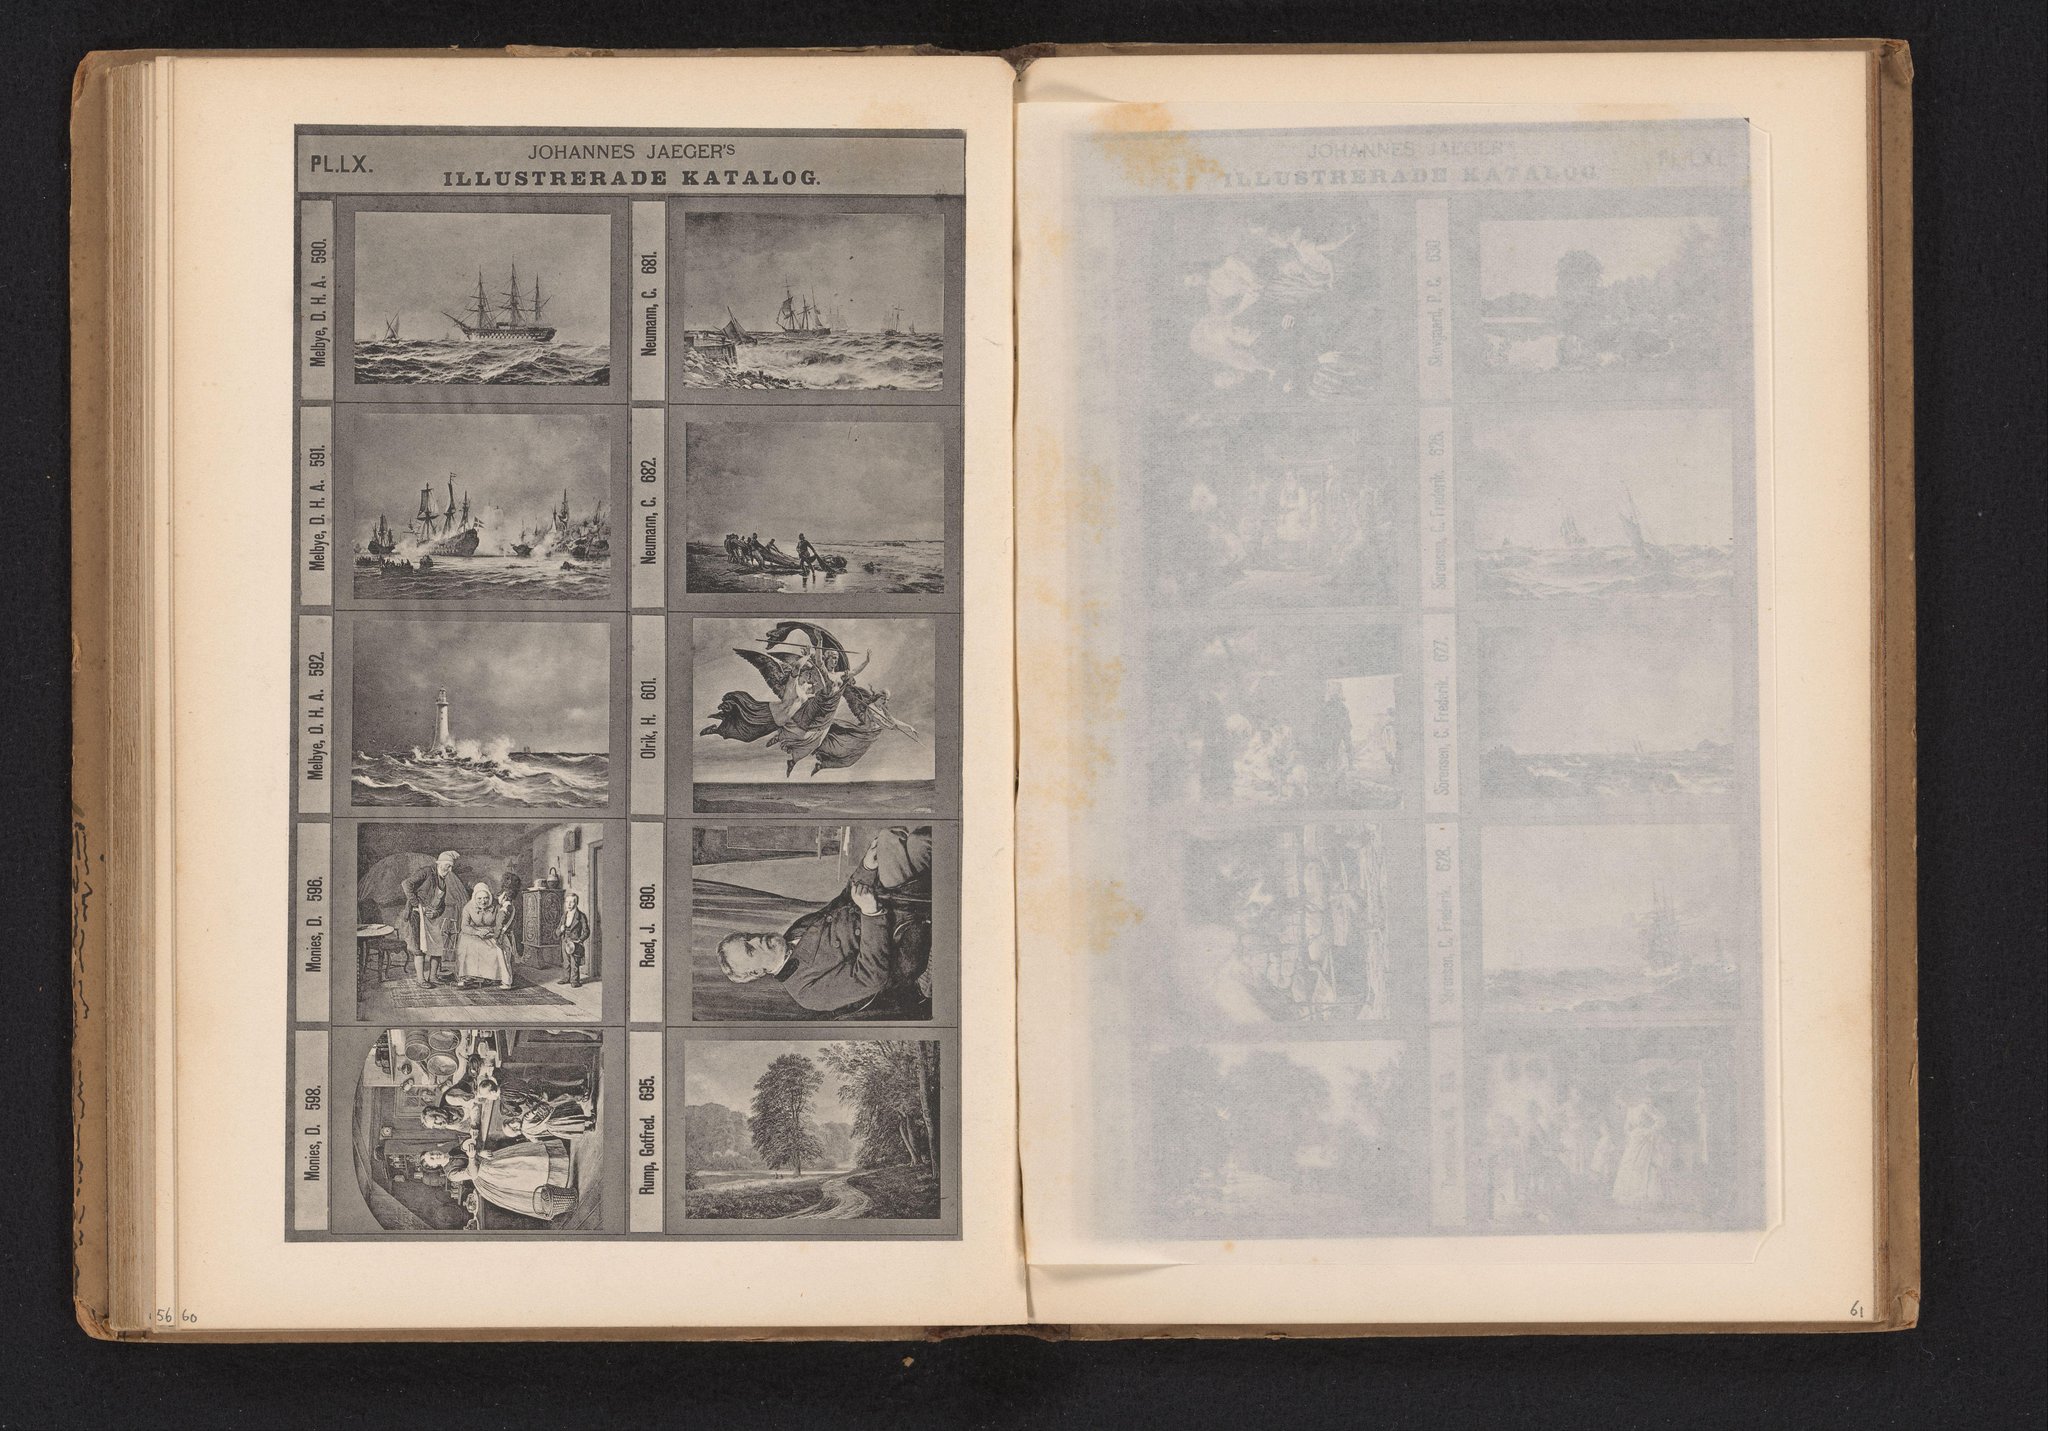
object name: reproduction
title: Johannes Jaeger's Illustrerade Katalog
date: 1872-1882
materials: paper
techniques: photograph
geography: stockholm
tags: picture, painting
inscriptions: number: ‘PL. LX.’